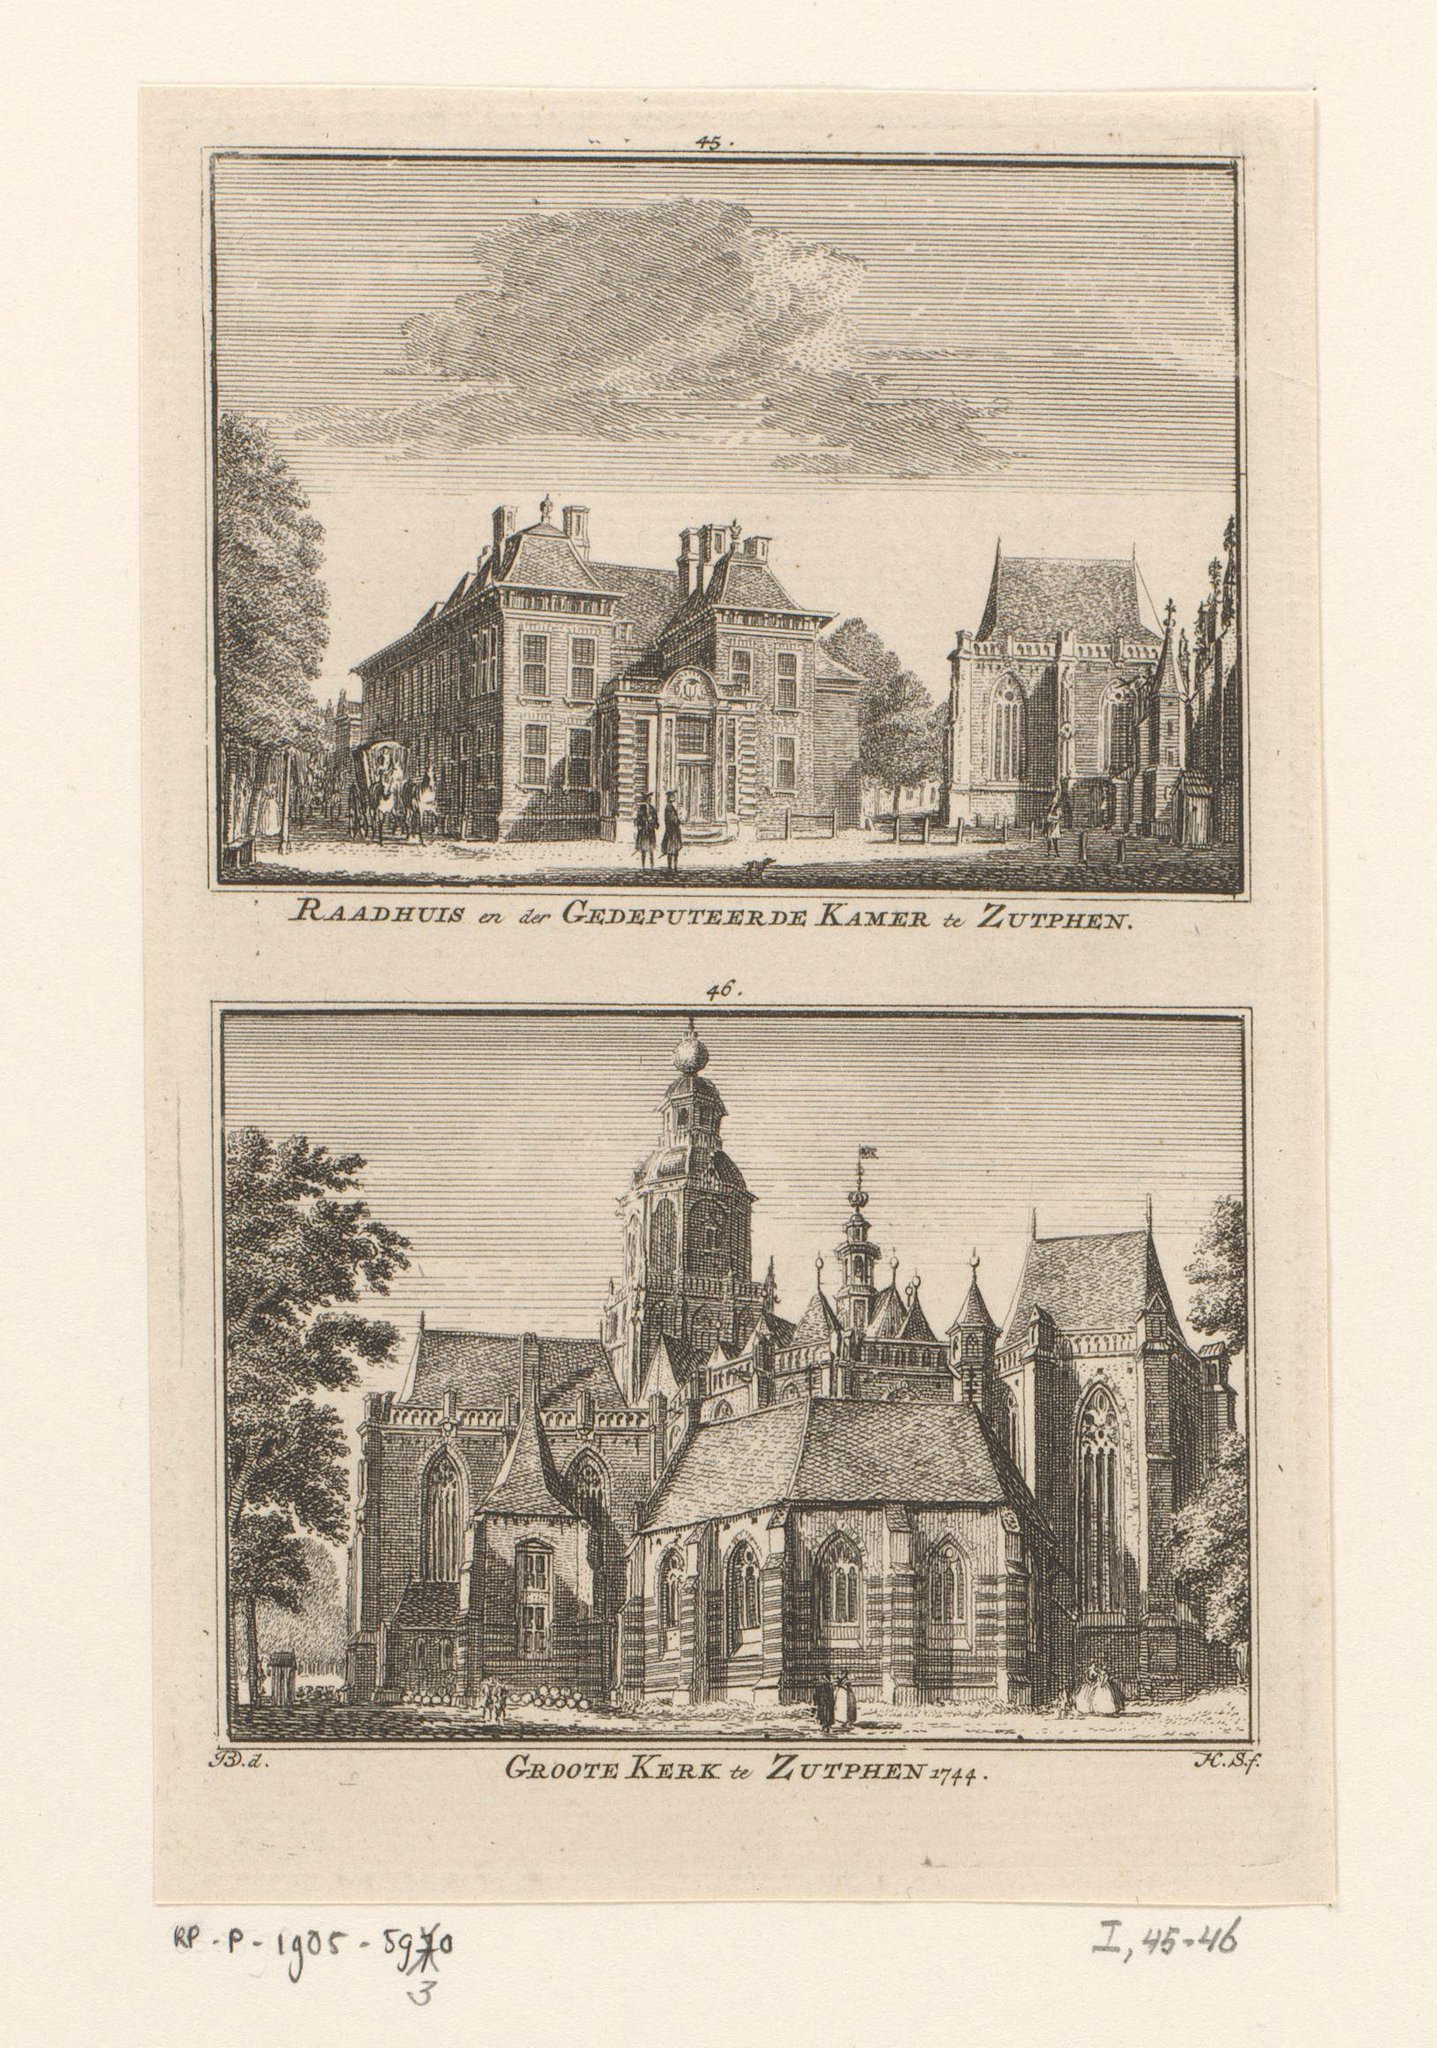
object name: print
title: Raadhuis en der Gedeputeerde Kamer te Zutphen/ Groote Kerk te Zutphen 1744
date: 1745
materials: paper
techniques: etching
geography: haarlem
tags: church (exterior), prospect of city, town panorama, silhouette of city, public road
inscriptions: collector's mark: Lugt 2228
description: Prent gebruikt in: Het verheerlykt Nederland of kabinet van hedendaagsche gezigten van steden, dorpen, sloten ... en andere voornaame stad- en landgebouwen, in en omtrent alle de byzondere Vereenigde Nederlandsche Provinciën : gedurende de laatste jaaren door vermaarden kunsttekenaren na het leven getekent en ... in 't koper gebragt ... dienende tot opheldering der beschryvinge van den Tegenwoordigen Staat der Vereenigde Nederlanden. Deel I, 1745. Amsterdam: Isaac Tirion, 1745-1774.